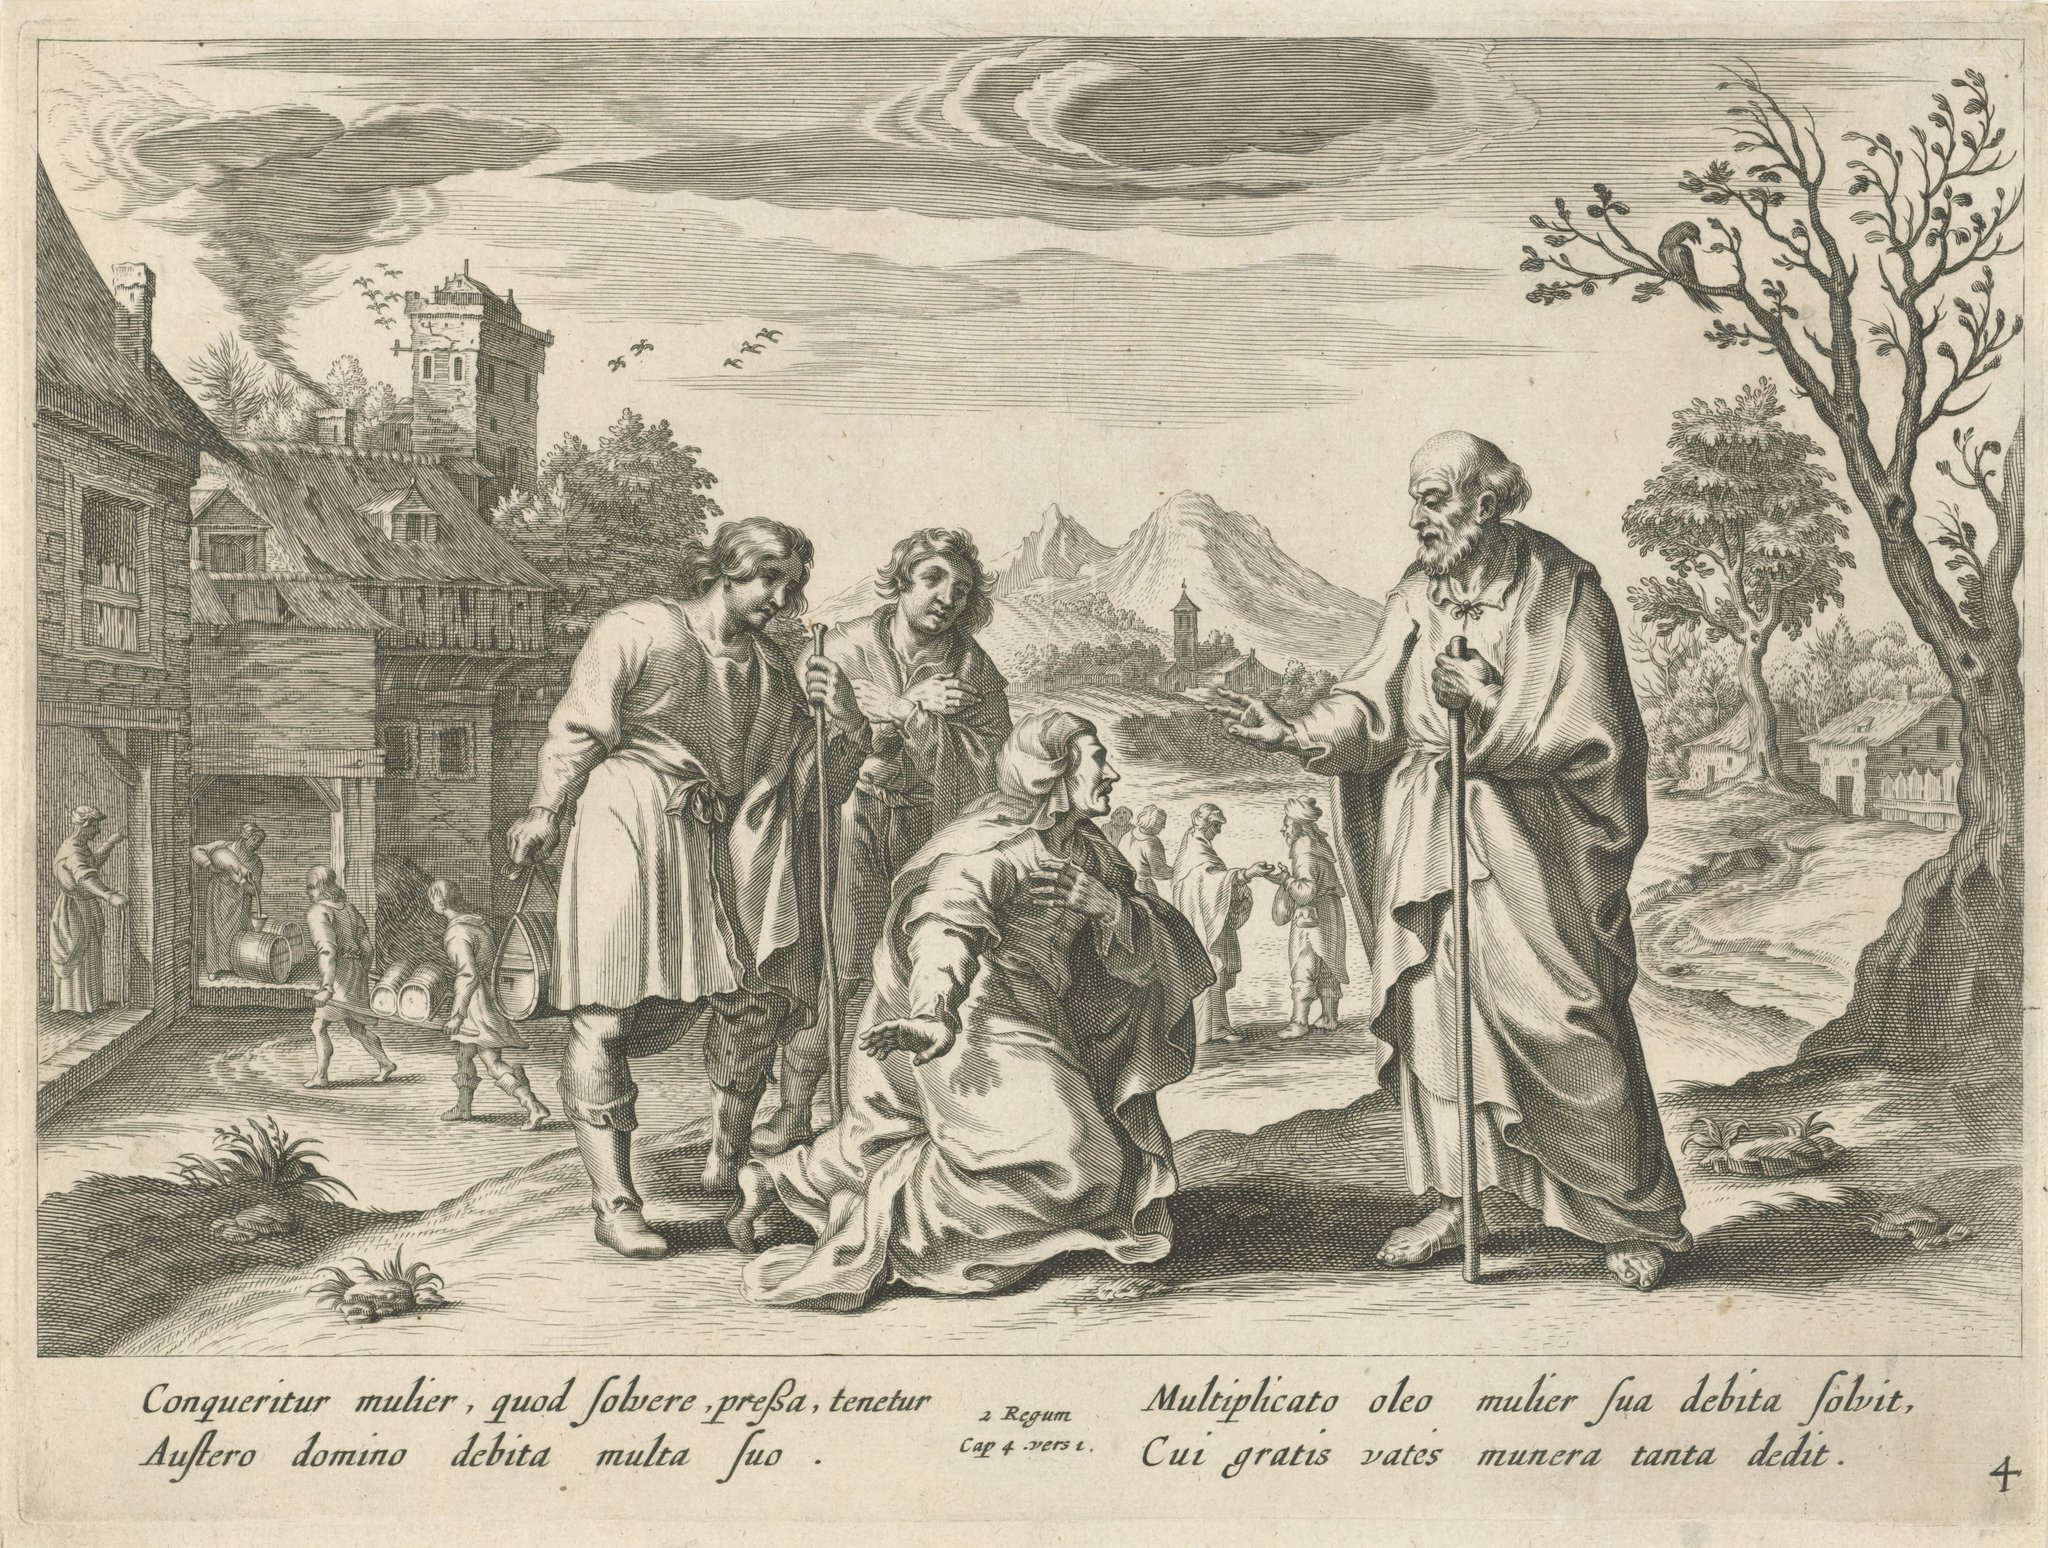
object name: print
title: Elisa helpt een arme weduwe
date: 1616-1636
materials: paper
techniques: engraving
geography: antwerp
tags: the widow's oil: the little oil a woman has in store increases so that she and her son are able to fill many borrowed jars with it (2 kings 4:1-7)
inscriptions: collector's mark: Lugt 2228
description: Een weduwe knielt voor Elisa en bedankt hem voor zijn hulp. Na het overlijden van haar man bleef de vrouw met een schuld achter, waardoor de schuldeiser haar twee zoons tot slaaf wilde maken. Om dat te voorkomen verrichte Elisa een wonder. Op zijn teken kon de weduwe met een kruikje oneindig veel vaten met olie vullen. Door de olie te verkopen kon ze haar schuld aflossen en haar zoons behouden. Op de achtergrond worden vaten met olie gevuld.